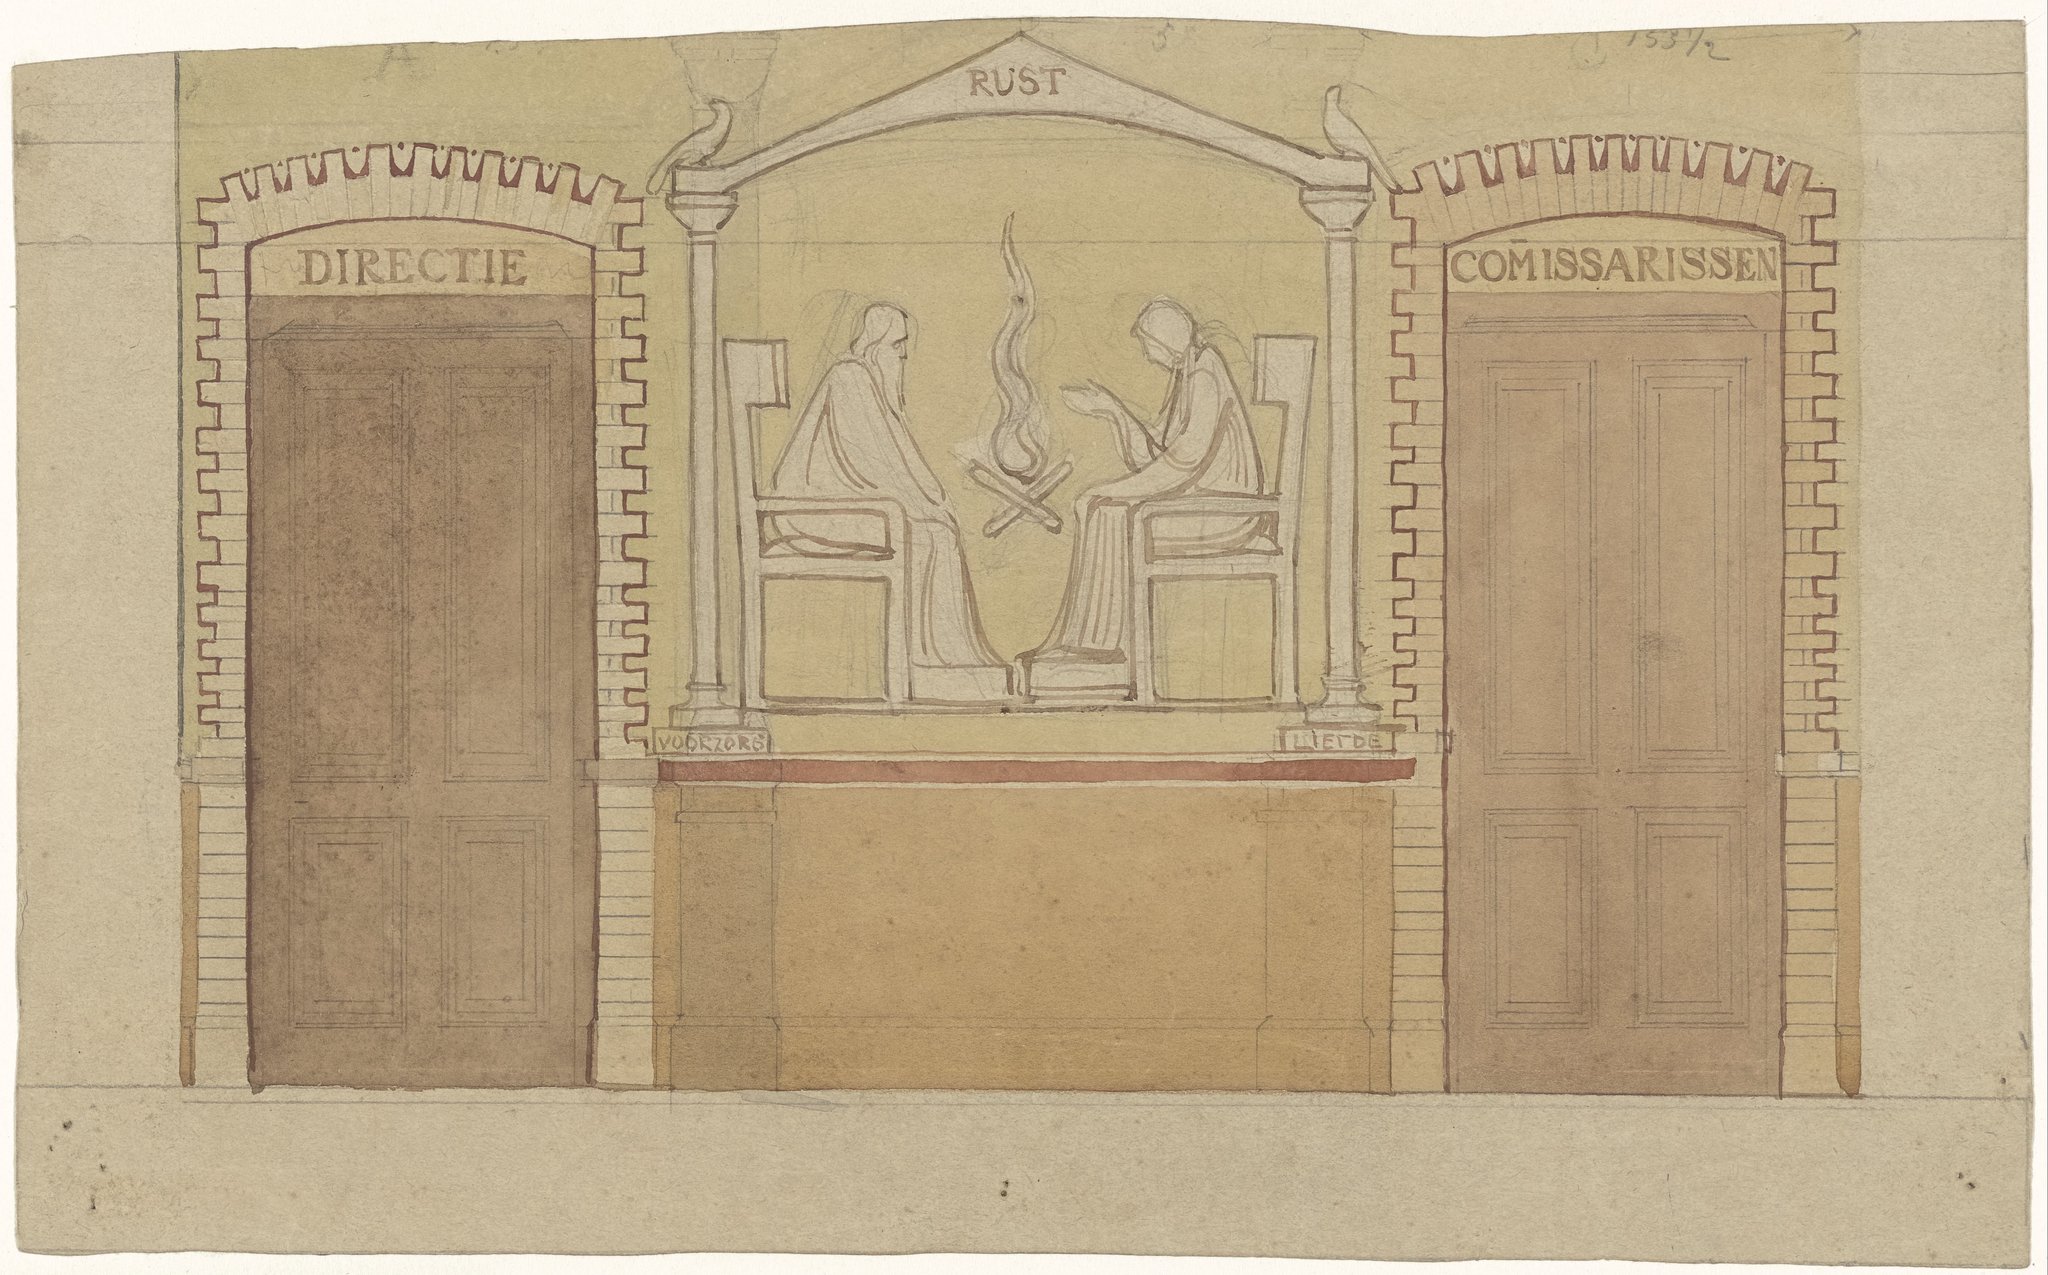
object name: watercolor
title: Rust van de oude dag, door Voorzorg en Liefde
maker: antoon derkinderen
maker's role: draughtsman, painter, print maker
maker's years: 1859-1925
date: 1869-1925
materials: paper, pencil, watercolor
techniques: brush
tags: care of the aged, warming oneself at a fire (or hearth, stove, fire-pan, brazier)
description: Ontwerp voor de wandschildering in het gebouw van de Algemeene Maatschappij van Levensverzekering en Lijfrente te Amsterdam: de Rust van de oude dag, door Voorzorg en Liefde.